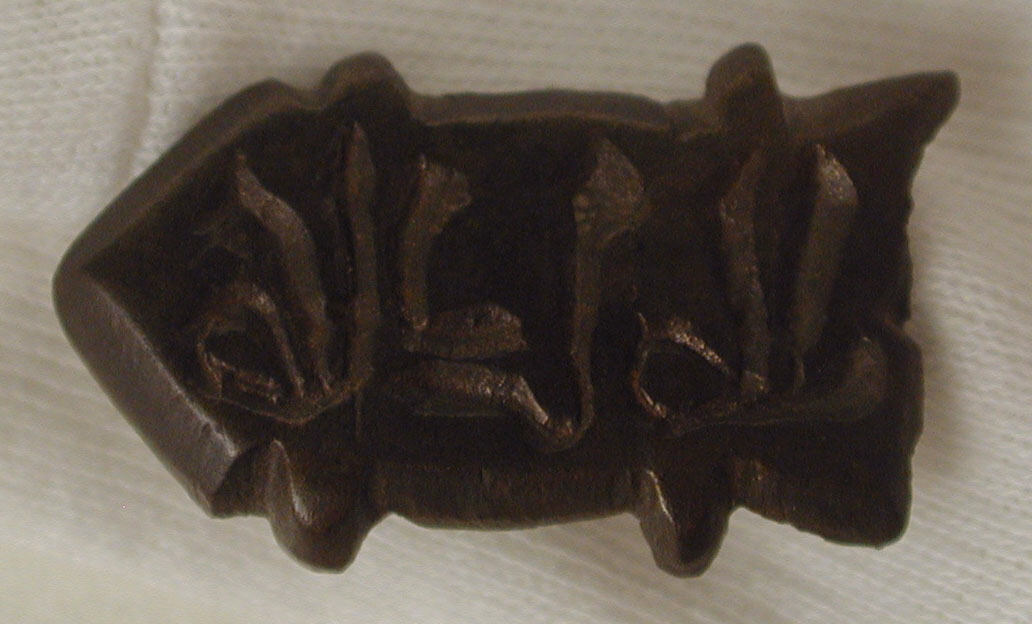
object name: belt fitting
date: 901-1000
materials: bronze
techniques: casting, gilding, incising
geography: iran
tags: arabic